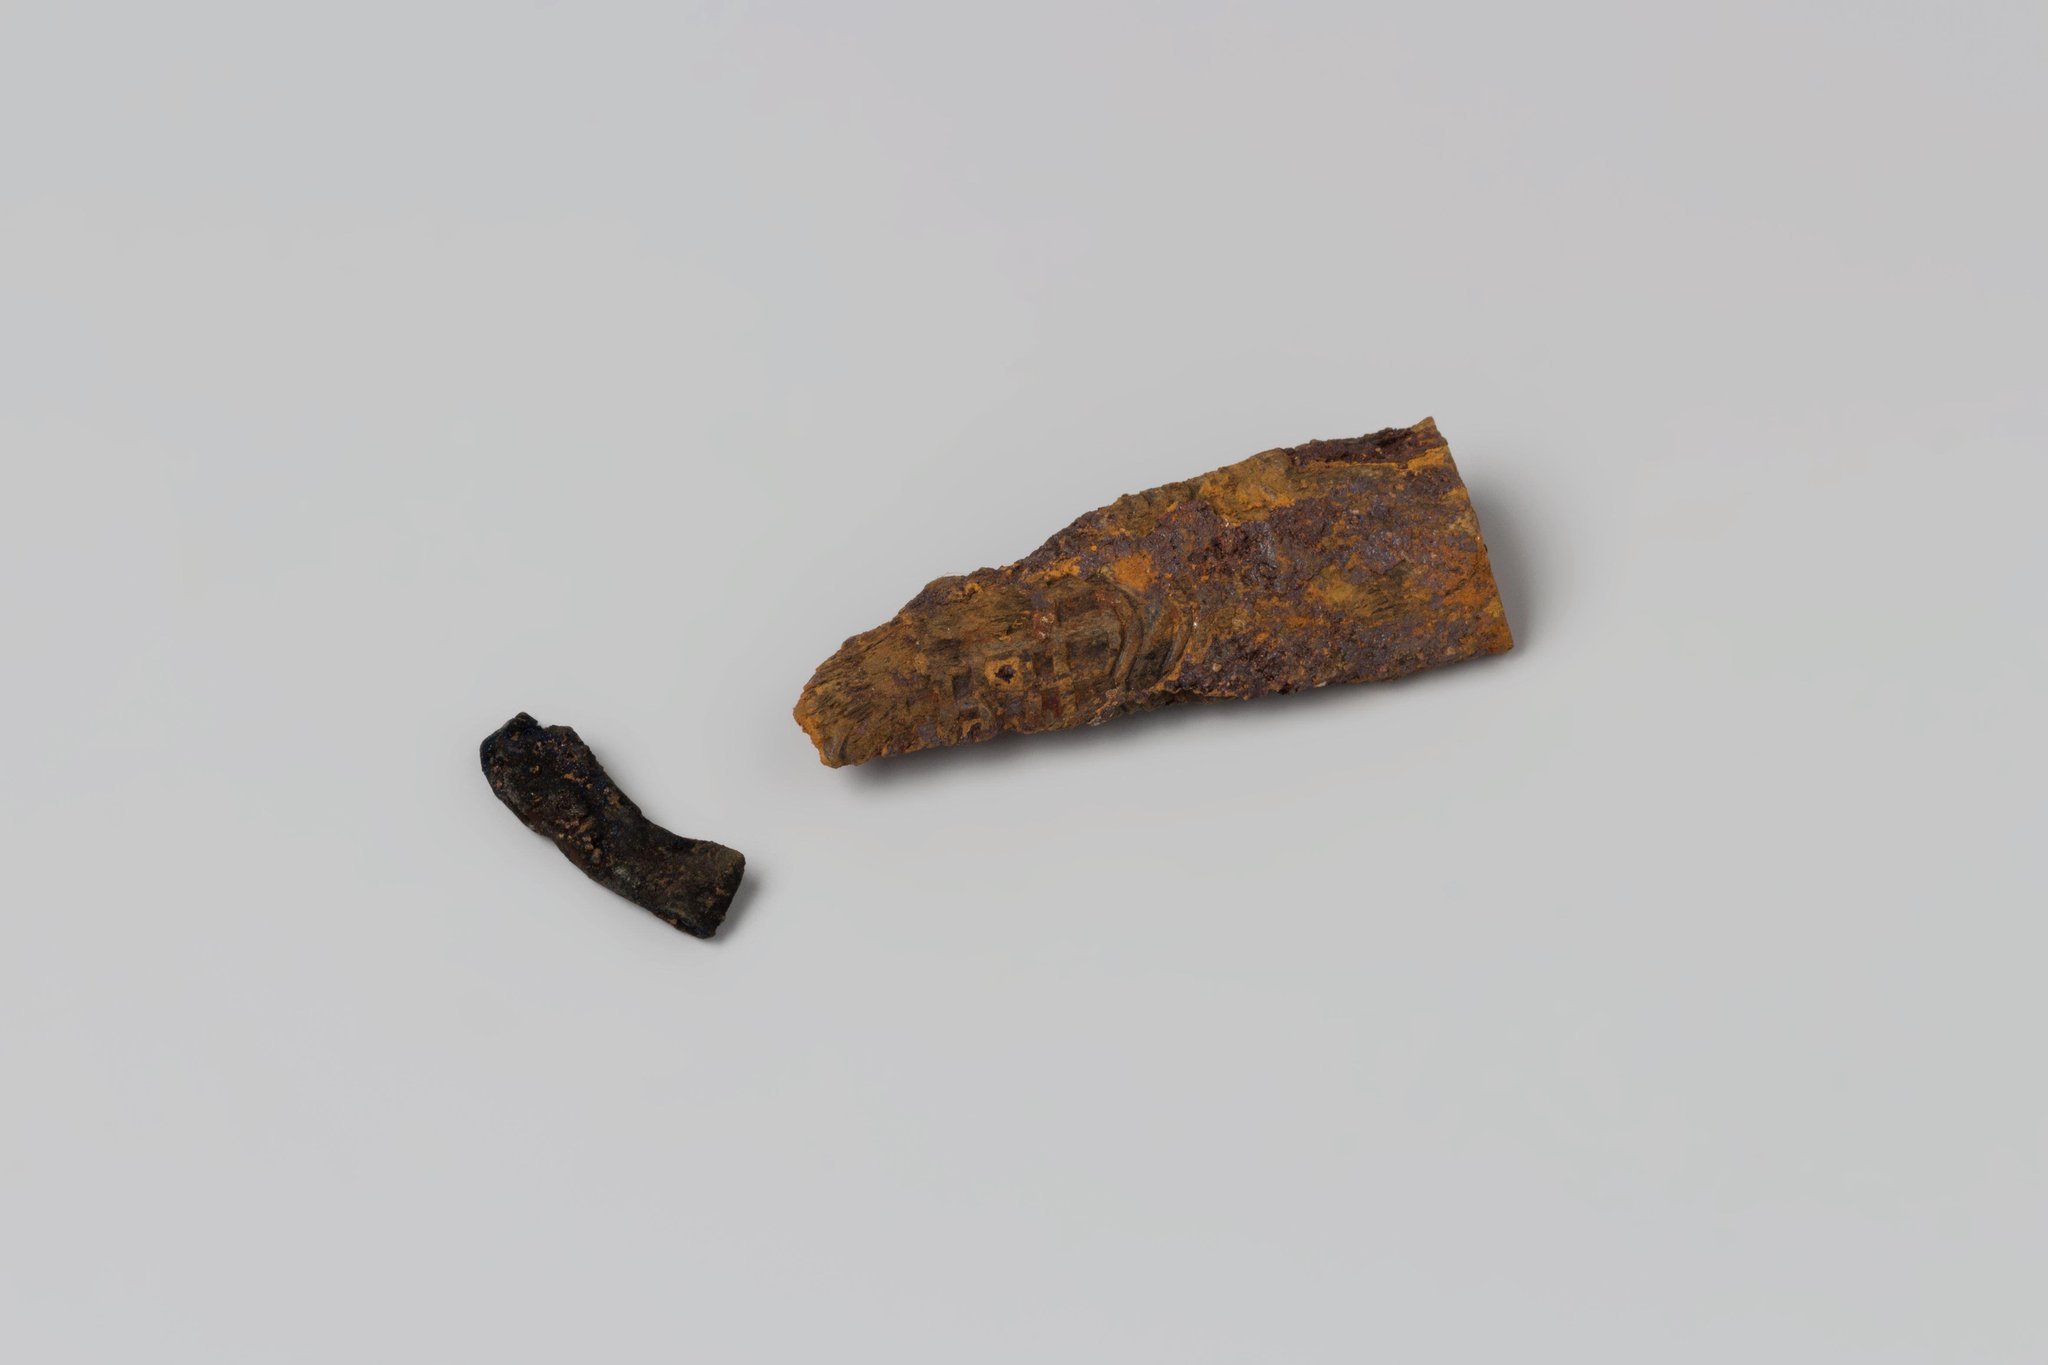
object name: fragment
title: Fragment messenheft en koper uit het wrak van de Oost-Indiëvaarder Hollandia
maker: Anonymous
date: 1700-1743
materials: copper, wood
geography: netherlands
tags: verenigde oostindische compagnie, hollandia (schip), annet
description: Knife, handle, cylindrical: tapering; fragm, id. NG 1979-403H.